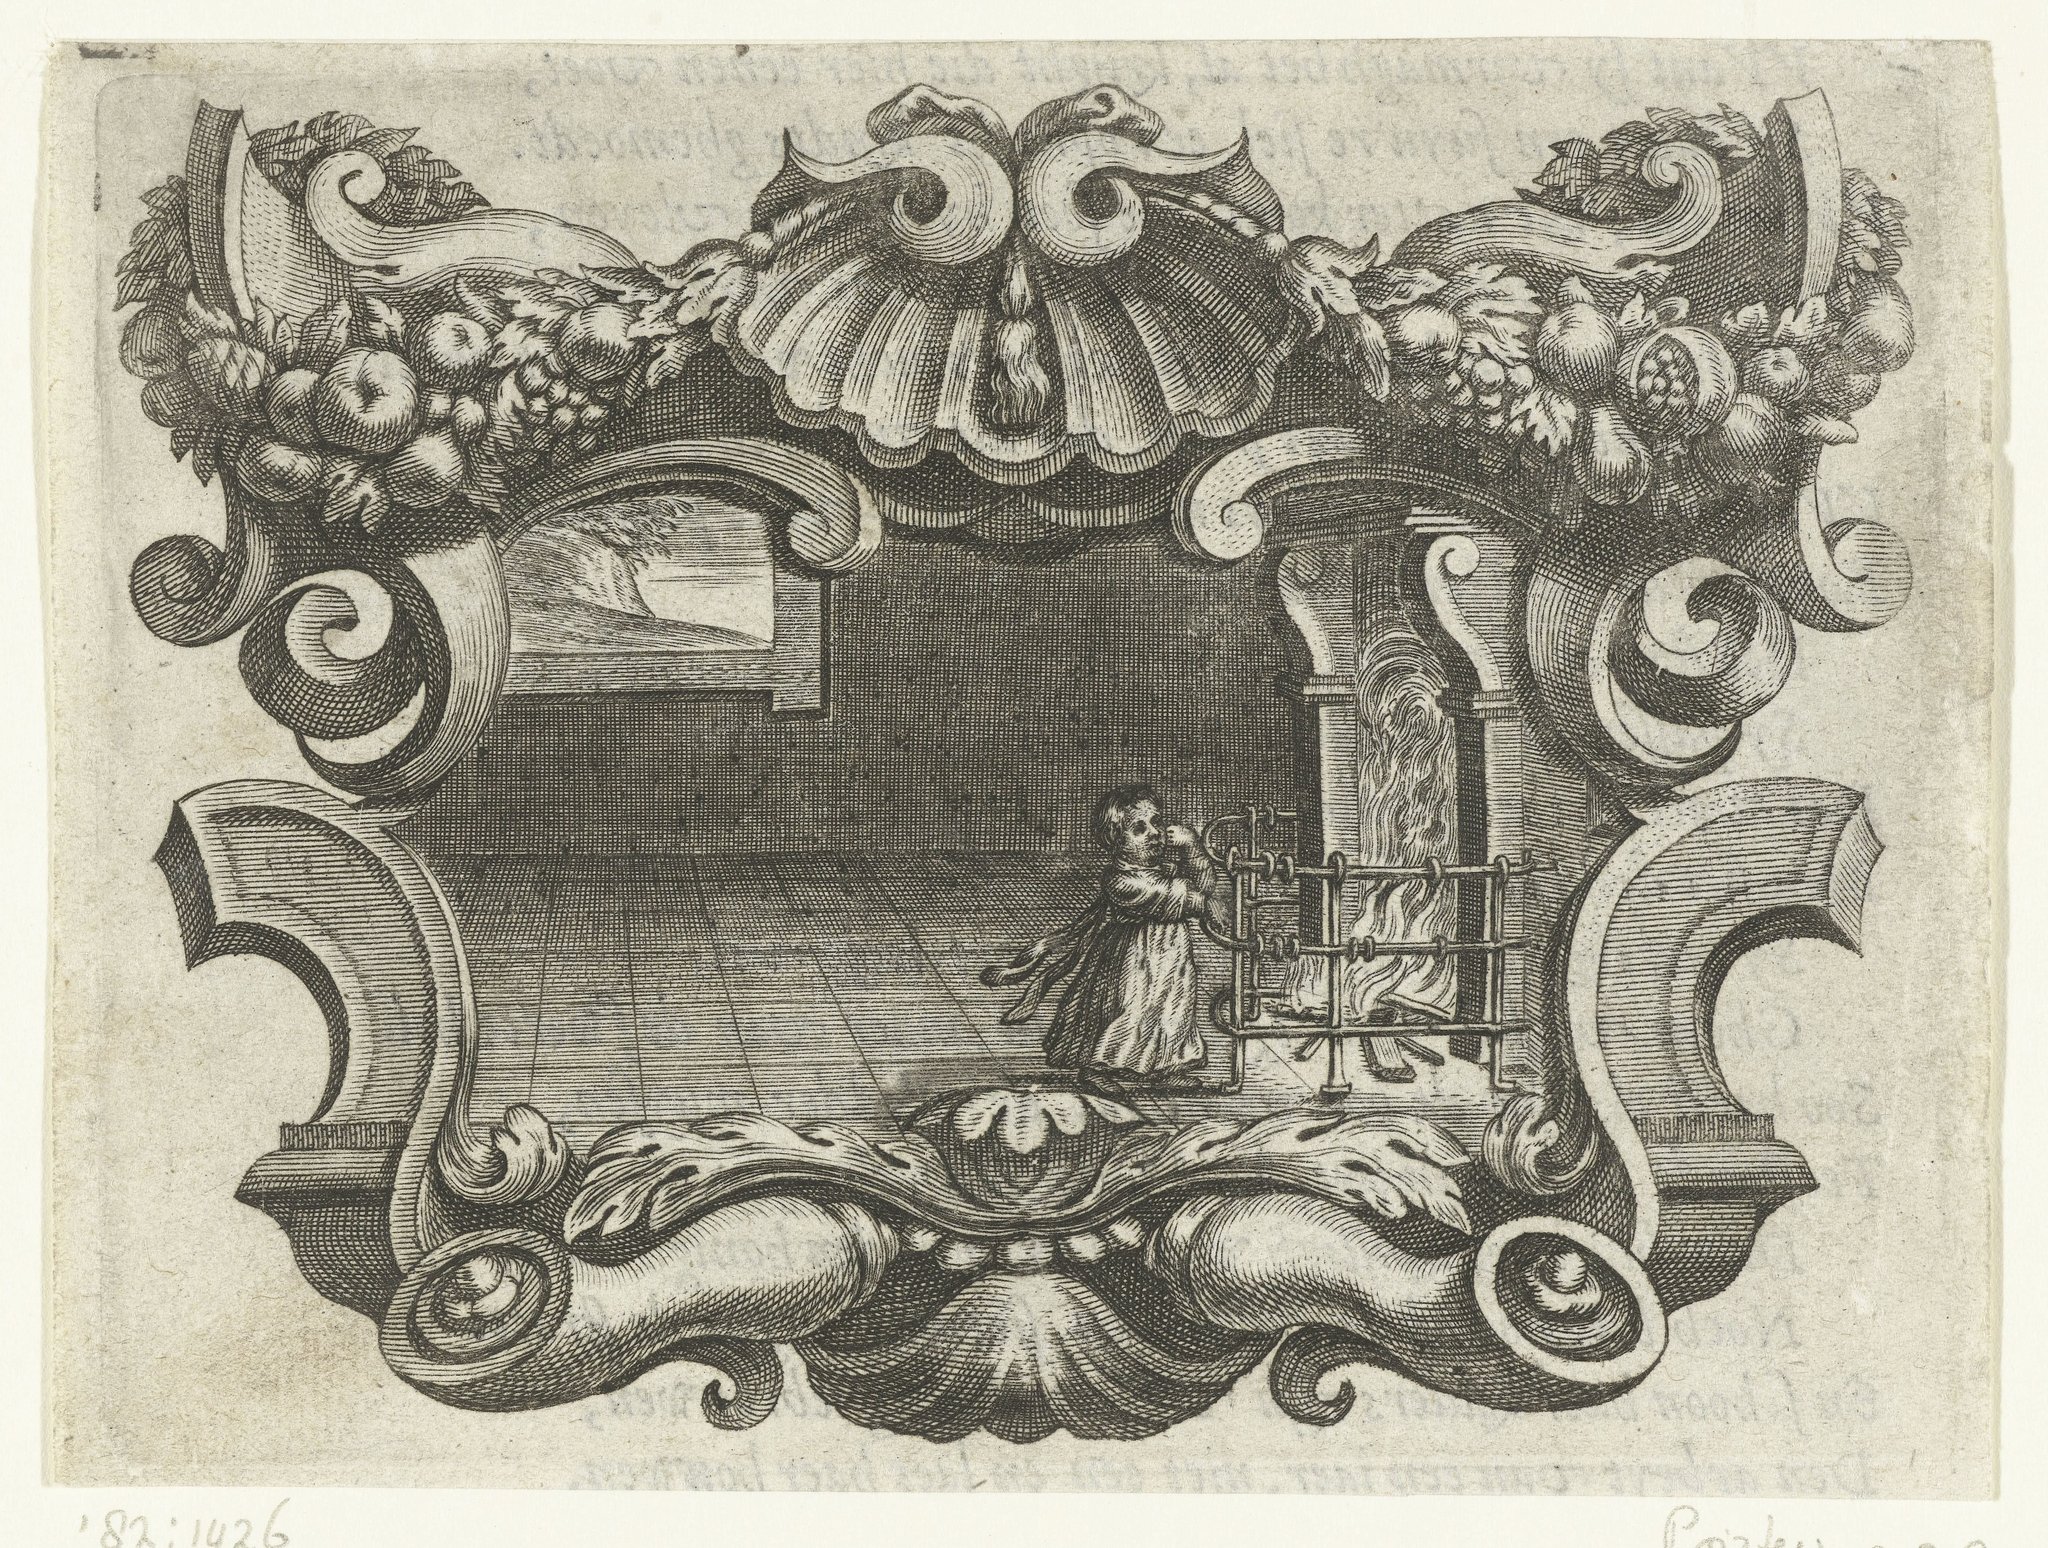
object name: print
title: Rolwerkcartouche met kind voor open haard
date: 1640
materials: paper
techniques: engraving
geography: antwerp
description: Uit serie van 38 cartouches, gedecoreerd met maskers, guirlandes van fruit en bloemen, schelpen en dieren.